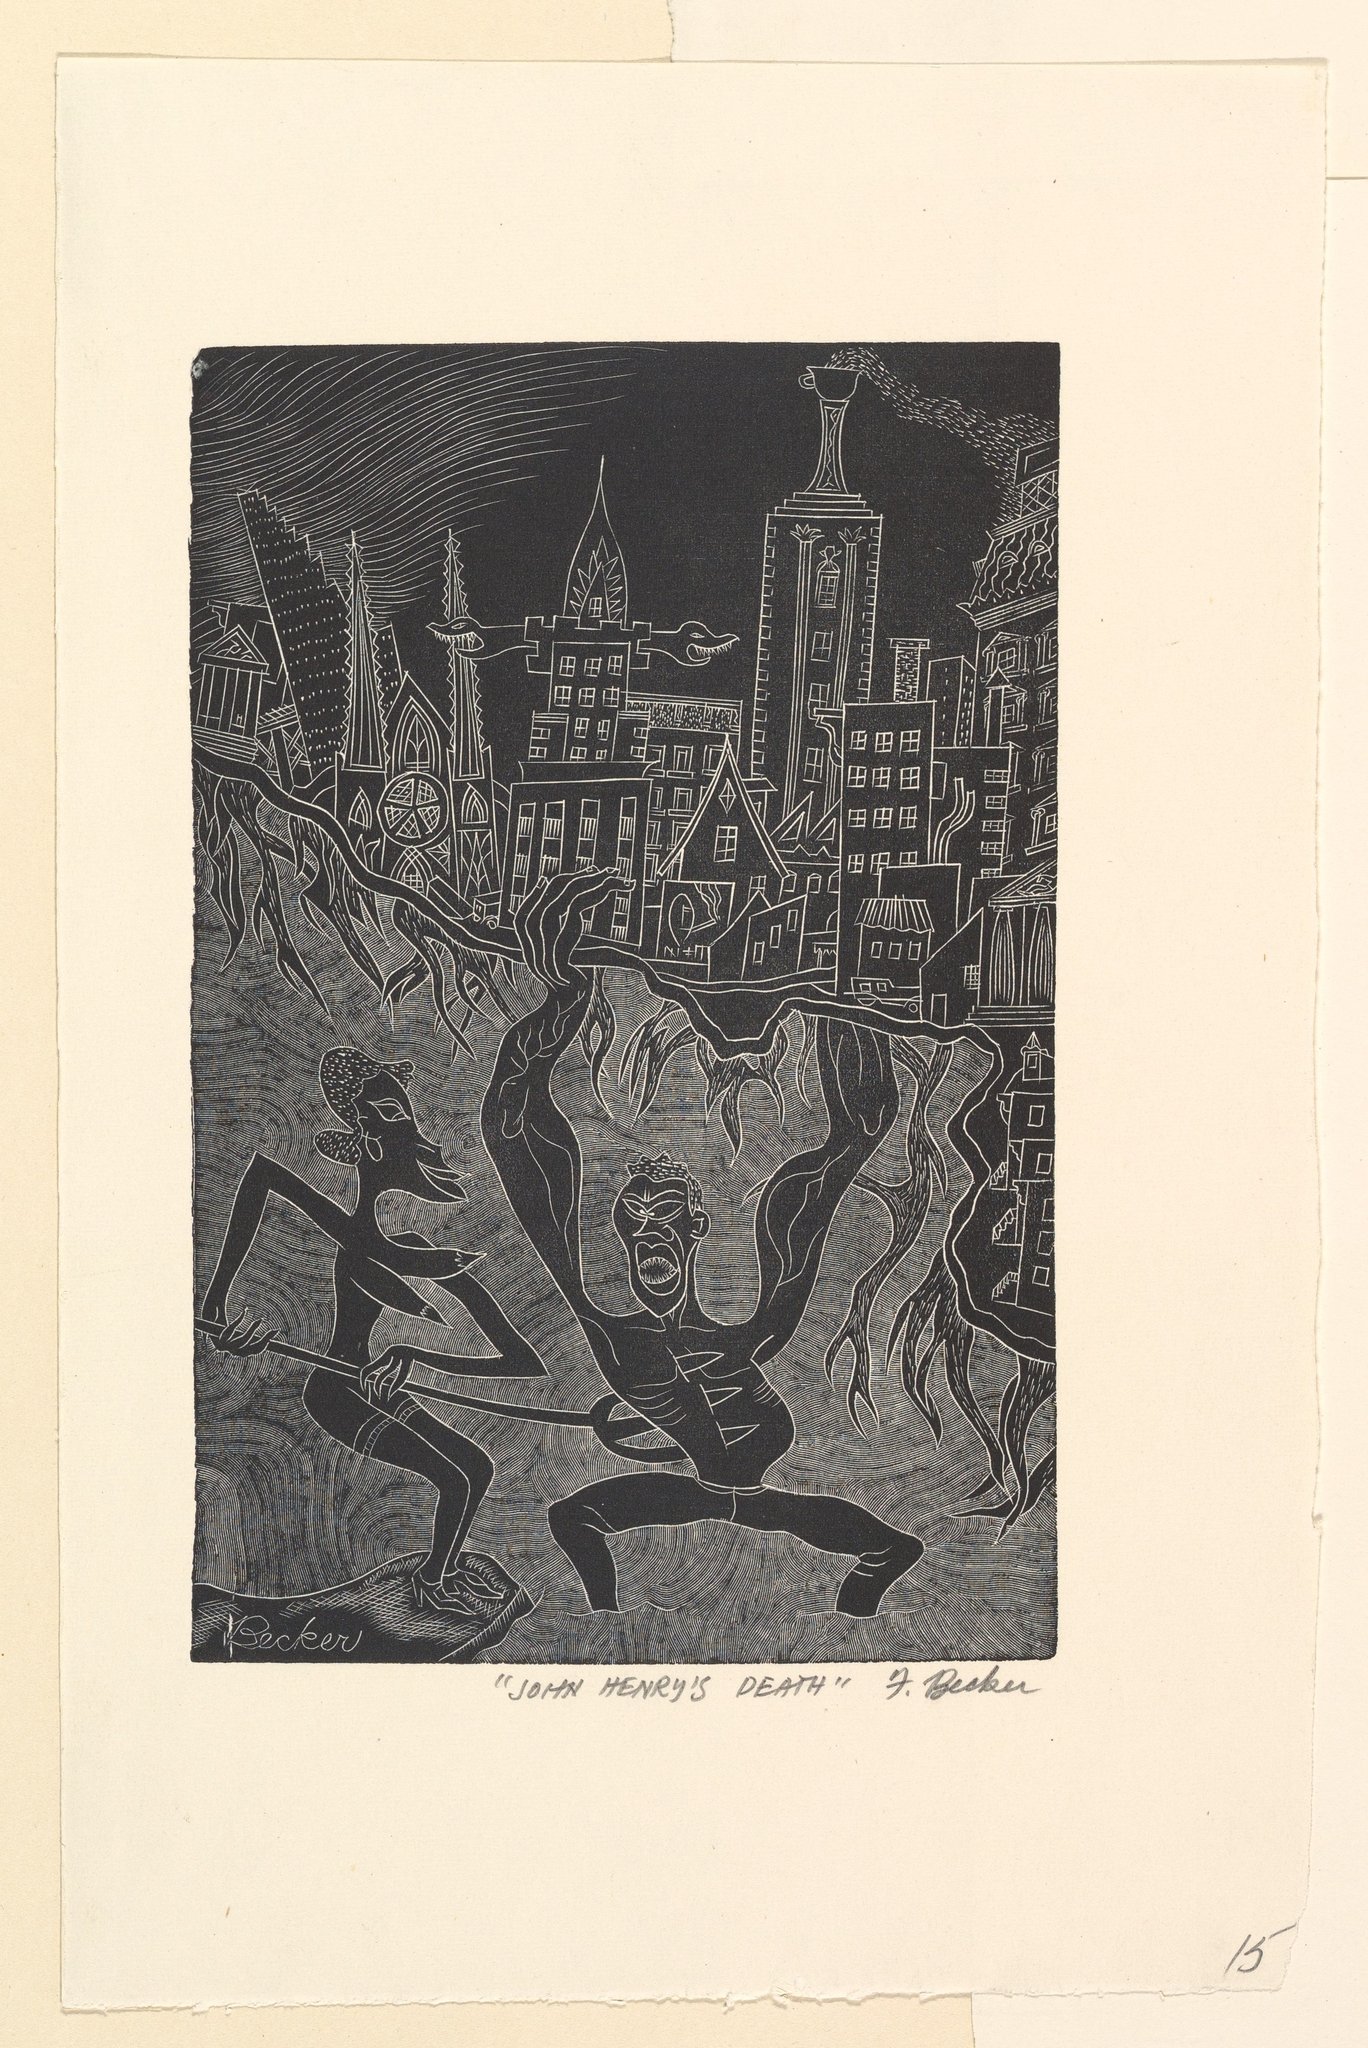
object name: print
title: John Henry's Death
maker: fred becker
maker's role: artist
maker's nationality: american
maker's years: 1913-2004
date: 1935-1940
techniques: engraving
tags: buildings,weapons,men,women,death